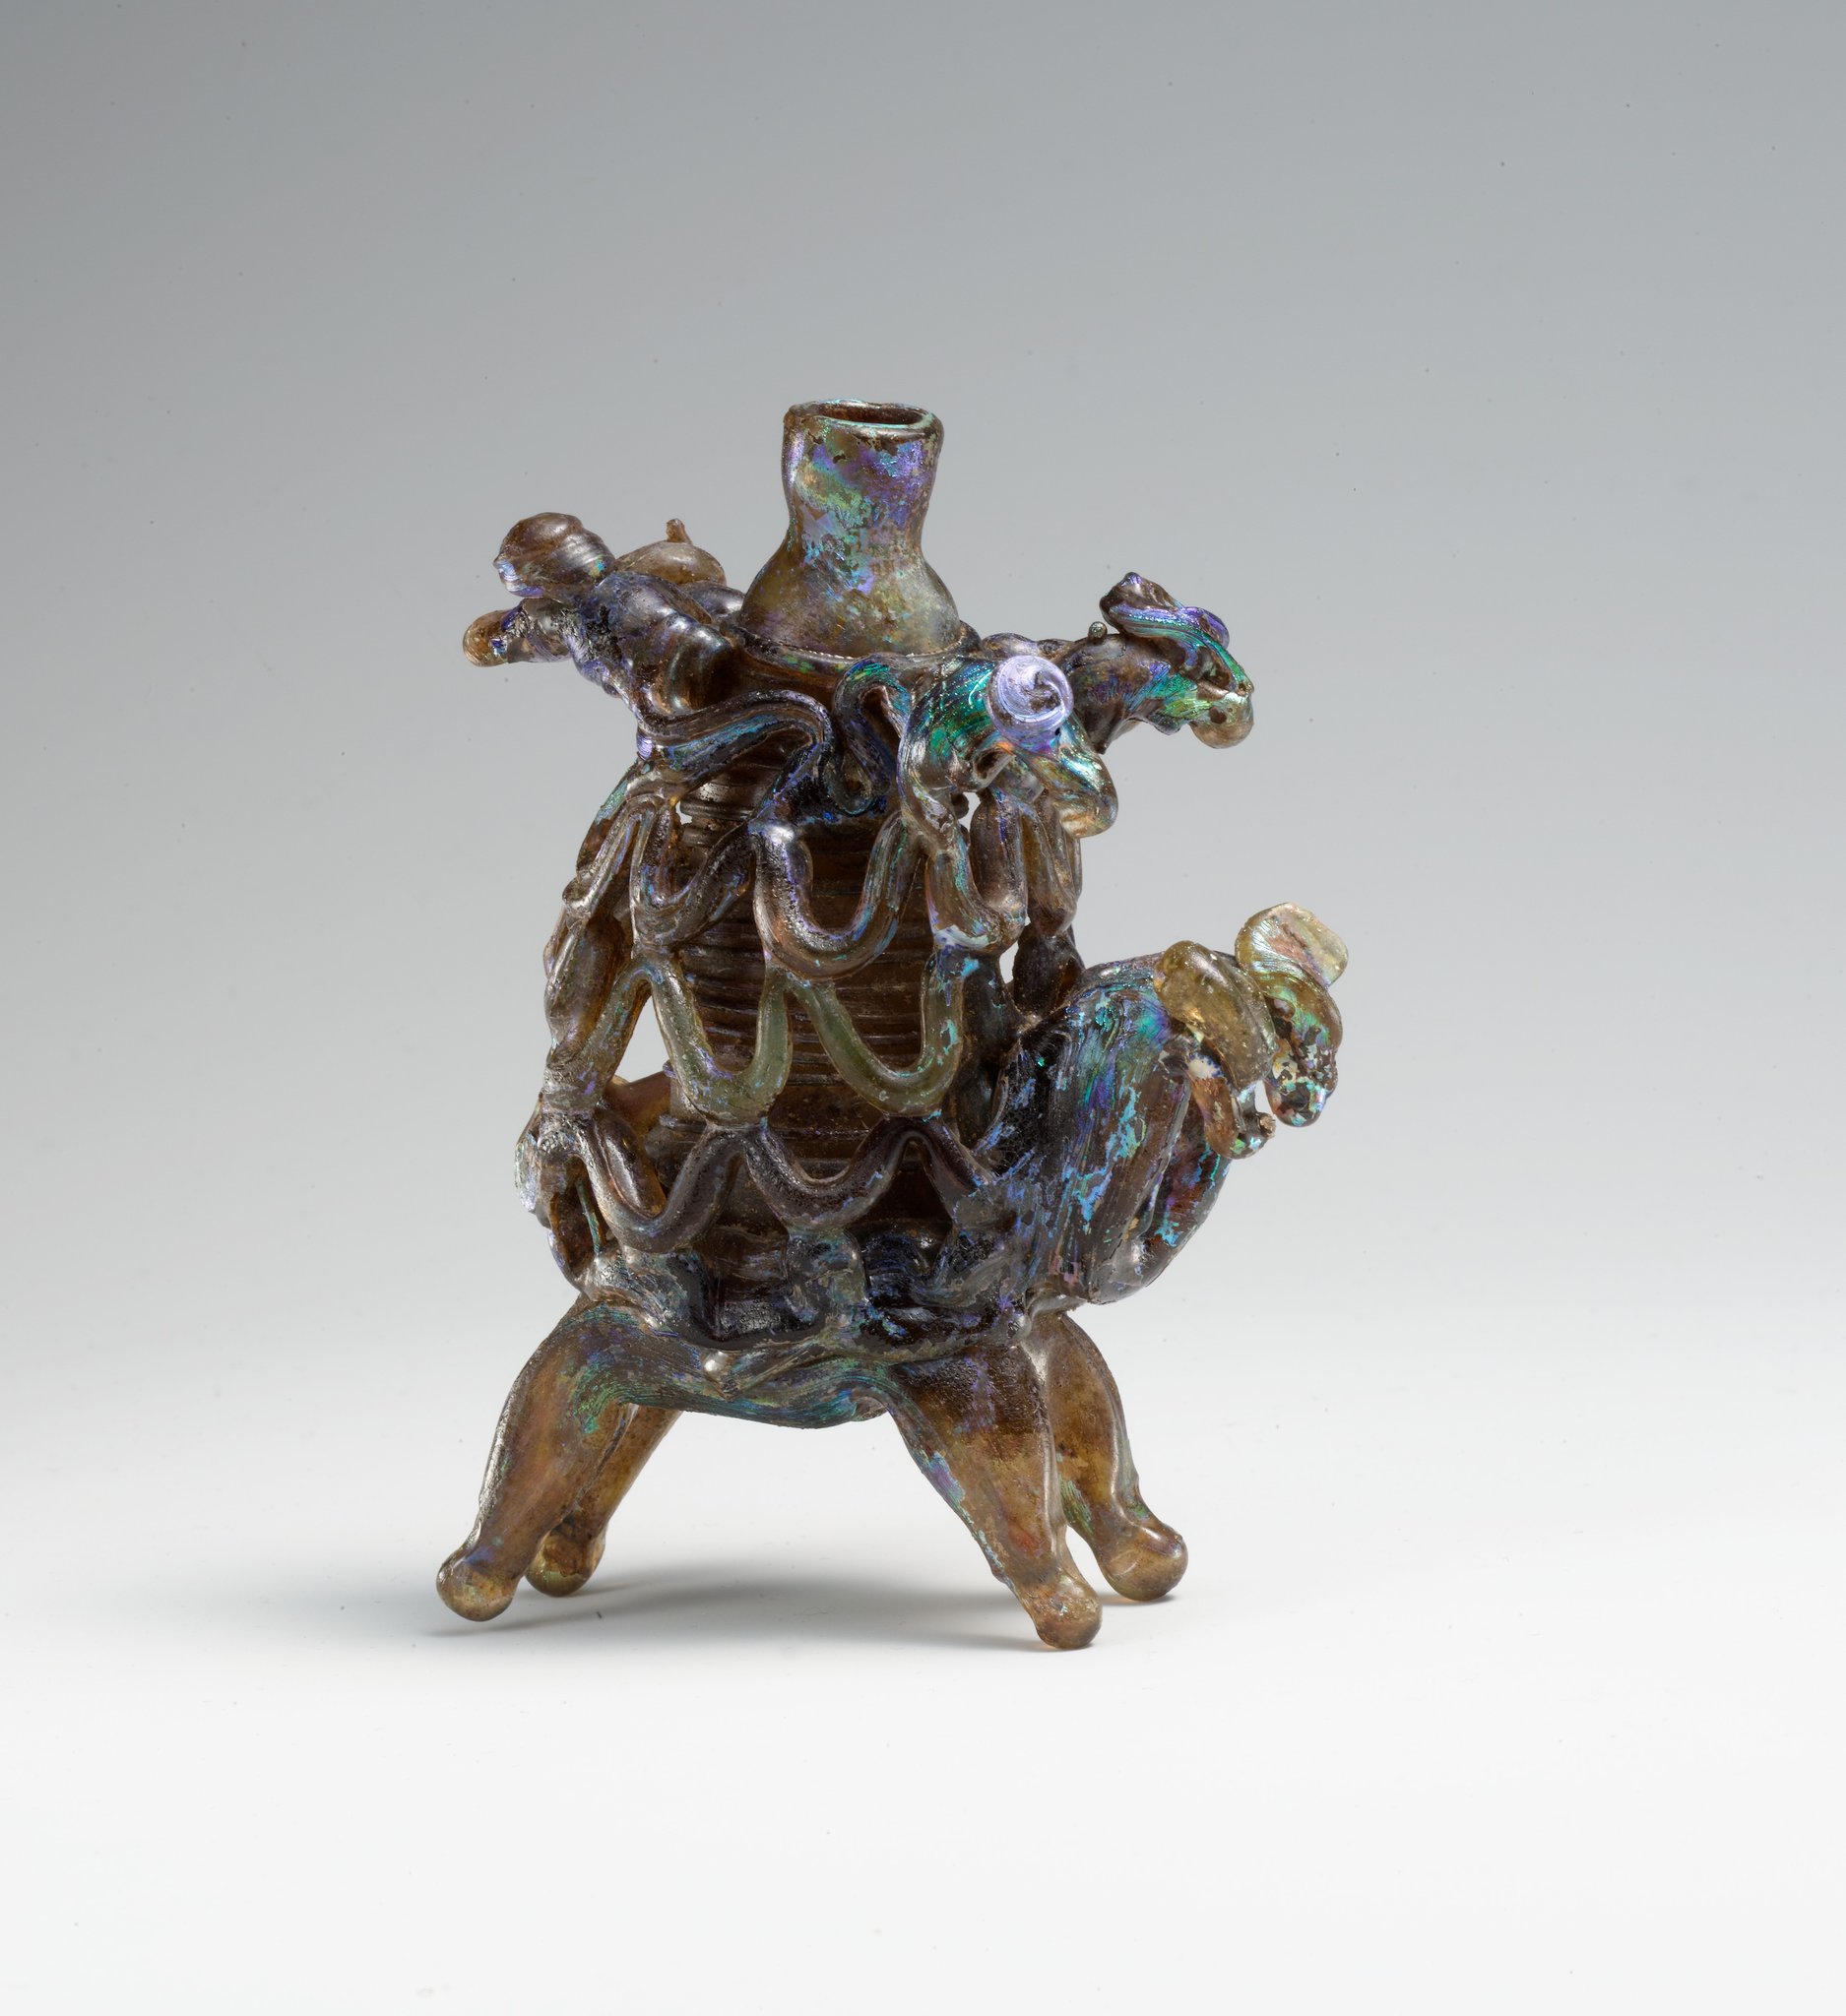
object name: flask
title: Animal Flask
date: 667-800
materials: amber, glass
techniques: glassblowing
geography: syria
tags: animals